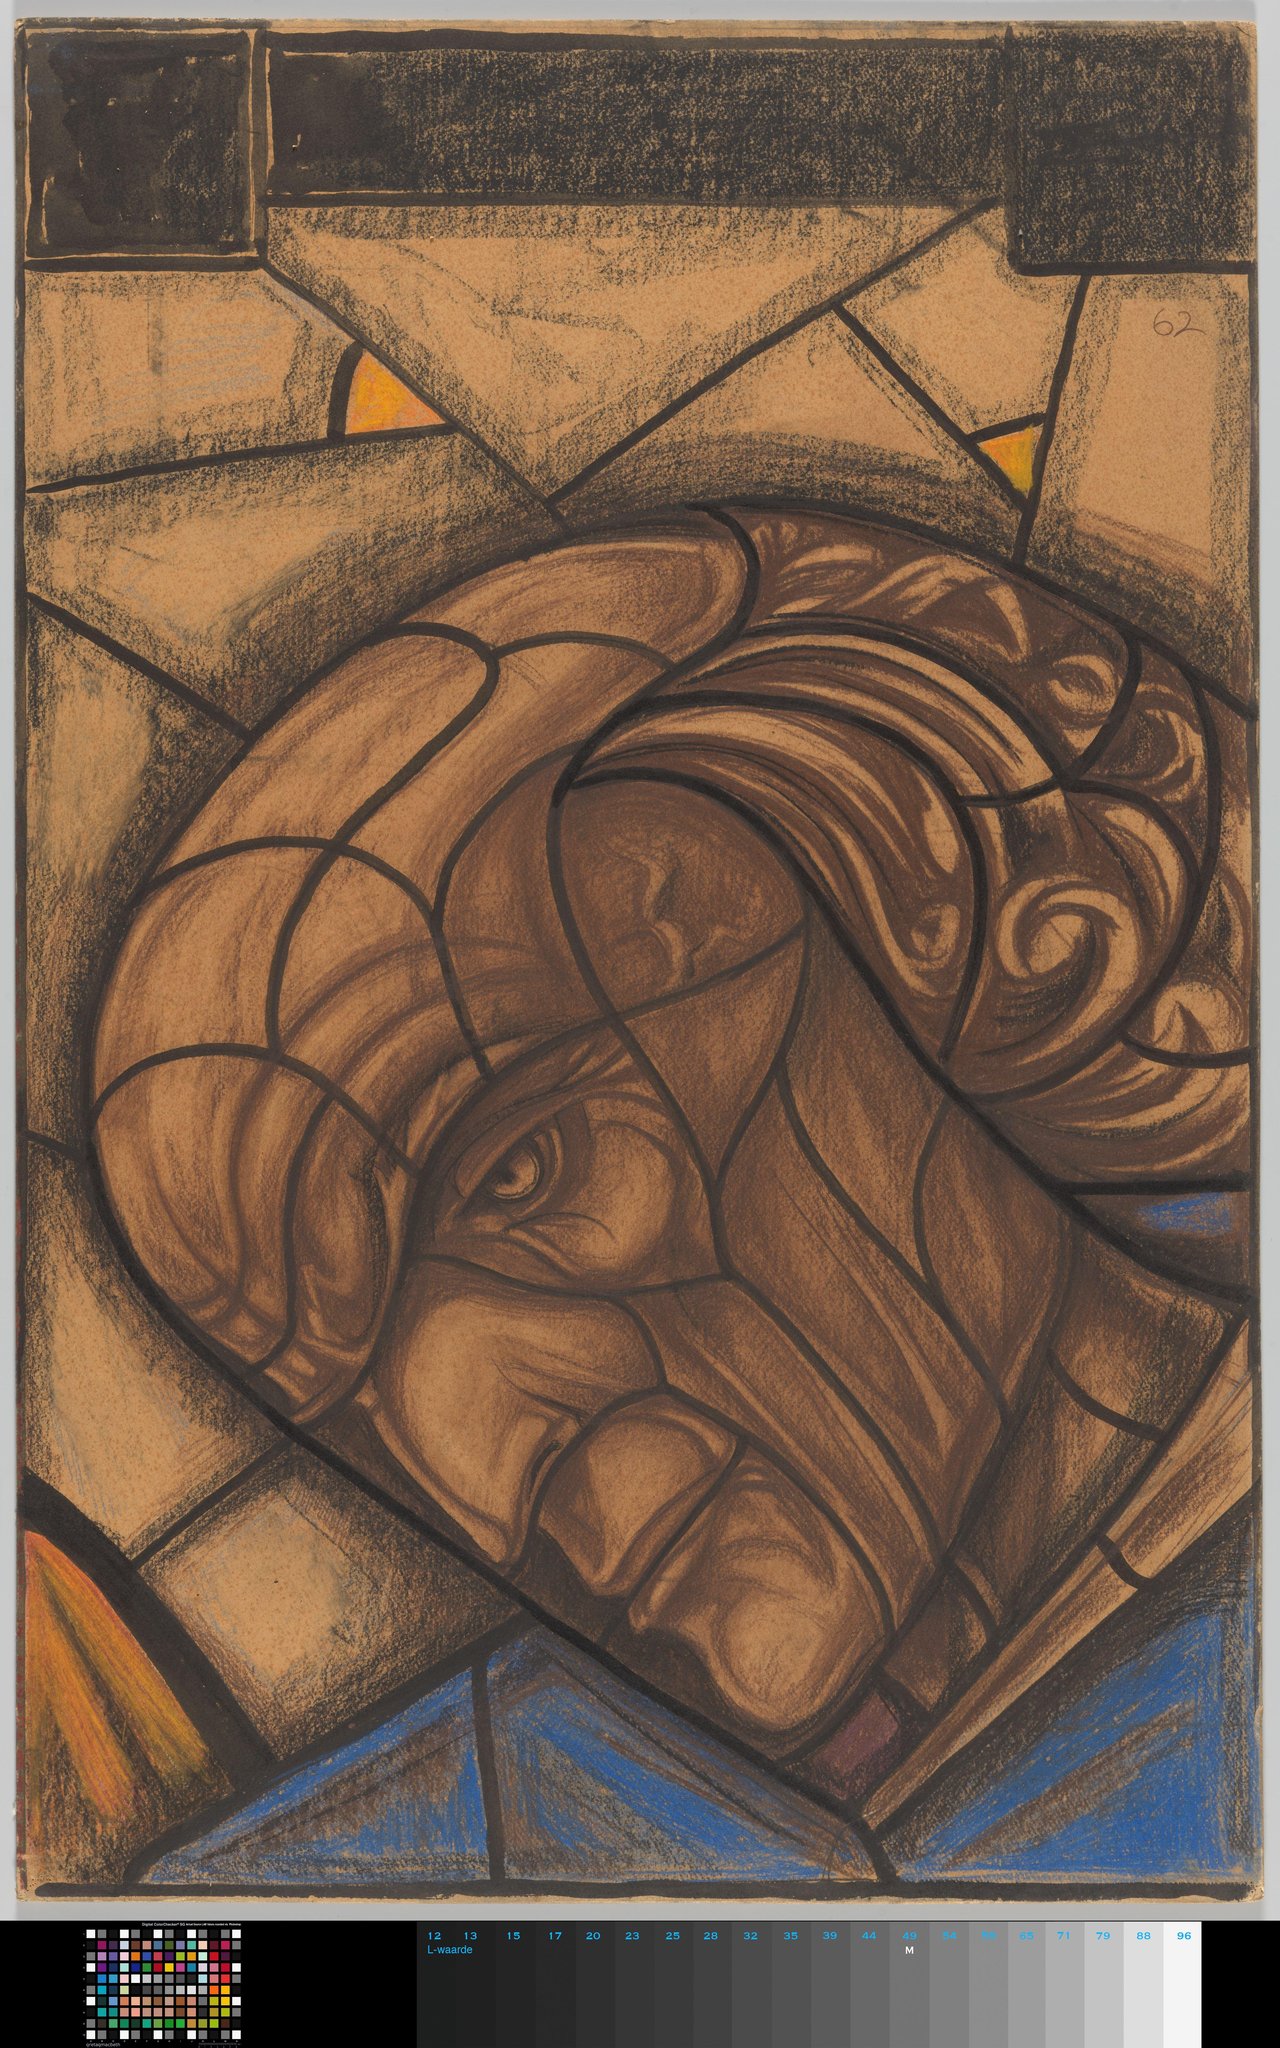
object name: design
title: Ontwerp voor raam in het Zuidertransept van de Dom te Utrecht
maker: richard nicolaüs roland holst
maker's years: 1868-1938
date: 1878-1938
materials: cardboard, chalk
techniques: brush